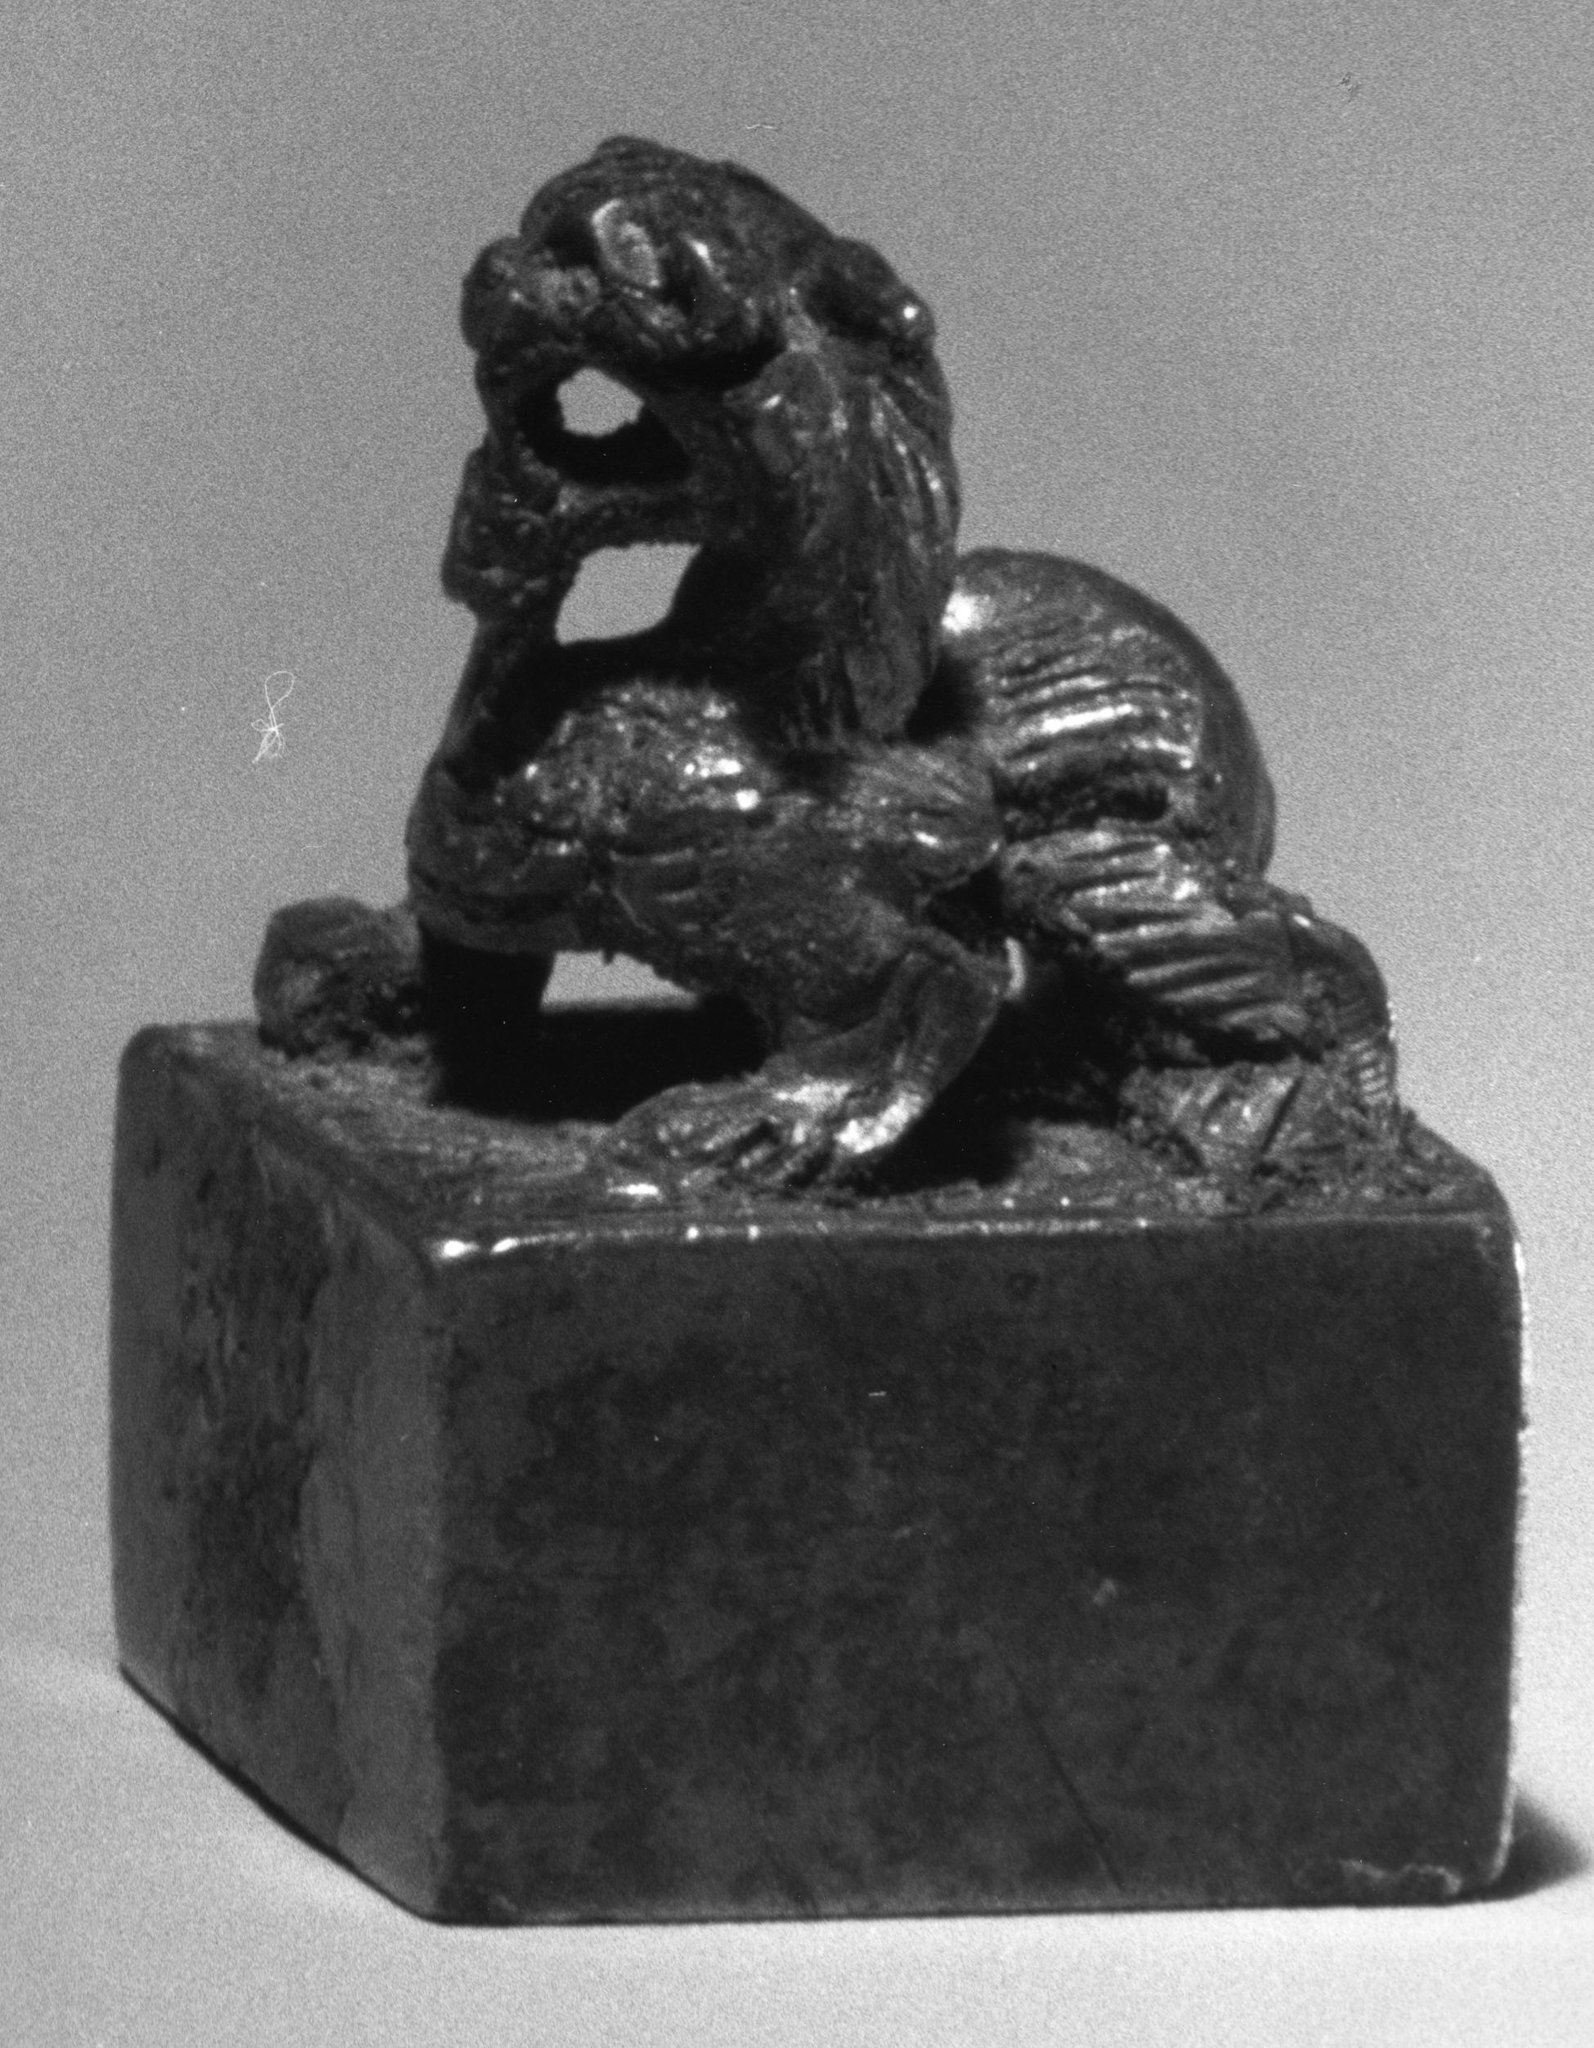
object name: seal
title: Seal with Knob in the Shape of a Chimera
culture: chinese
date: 201-300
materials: gilt silver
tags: mythical creatures